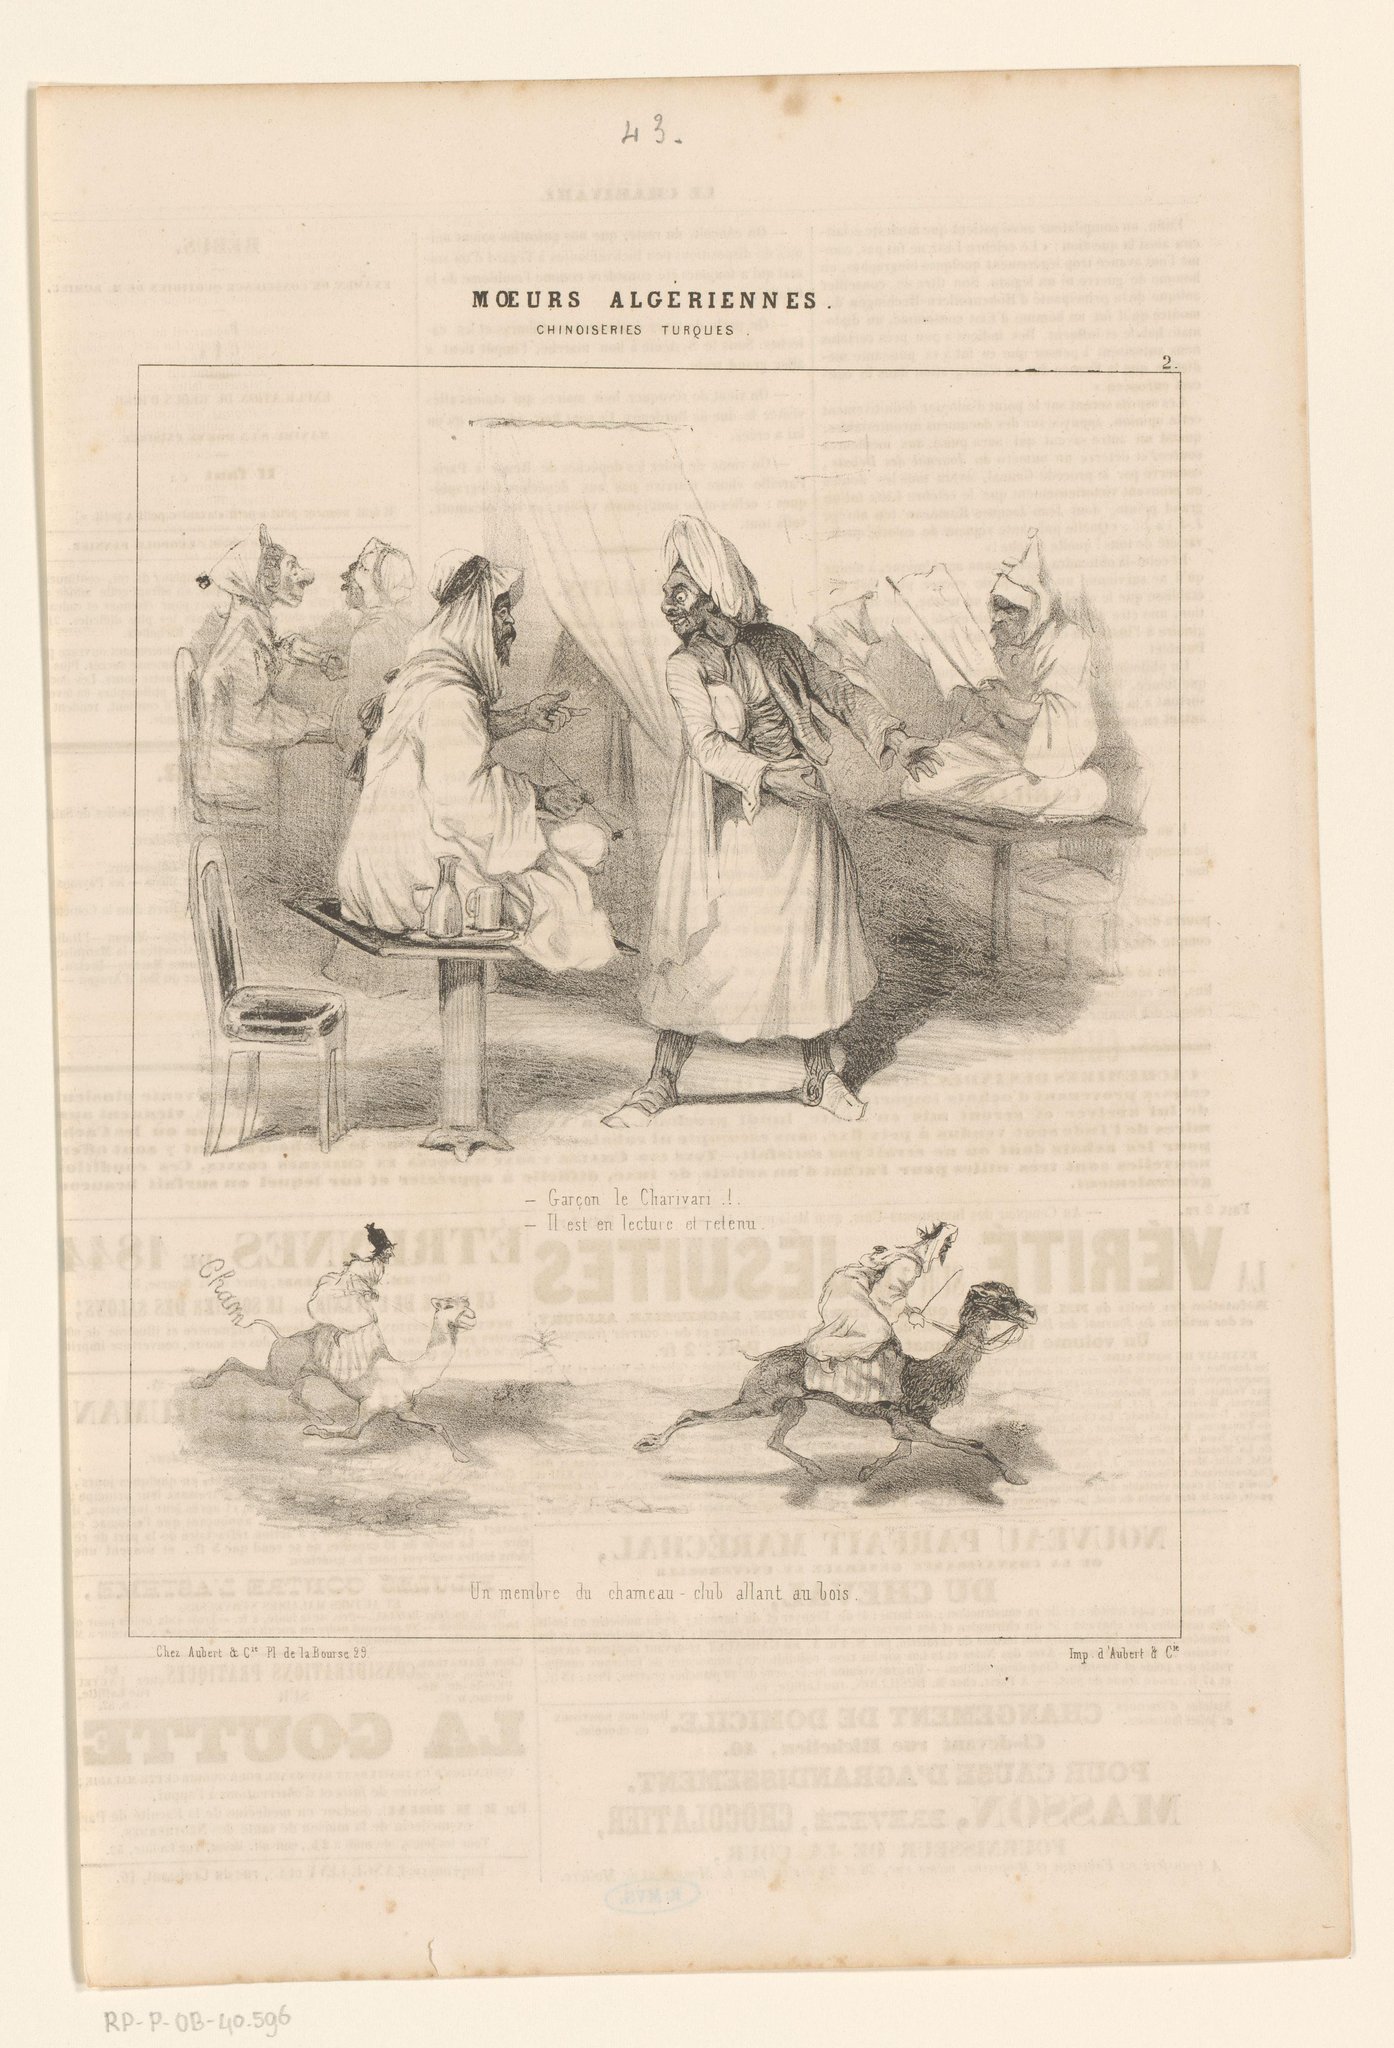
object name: cartoon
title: Un membre du chameau-club allant au bois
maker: cham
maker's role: print maker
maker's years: 1818-1879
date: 1843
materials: paper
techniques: letterpress printing, lithograph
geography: paris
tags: water-pipe, hookah, narghile, hoofed animals: camel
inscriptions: collector's mark: Lugt 2228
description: Prent uit: Le Charivari 12 (1843), nr. 356, 22 december 1843. De serie ‘Moeurs algériennes. Chinoiseries Turques’ is ook los van deze krant uitgegeven bij Aubert & Cie.